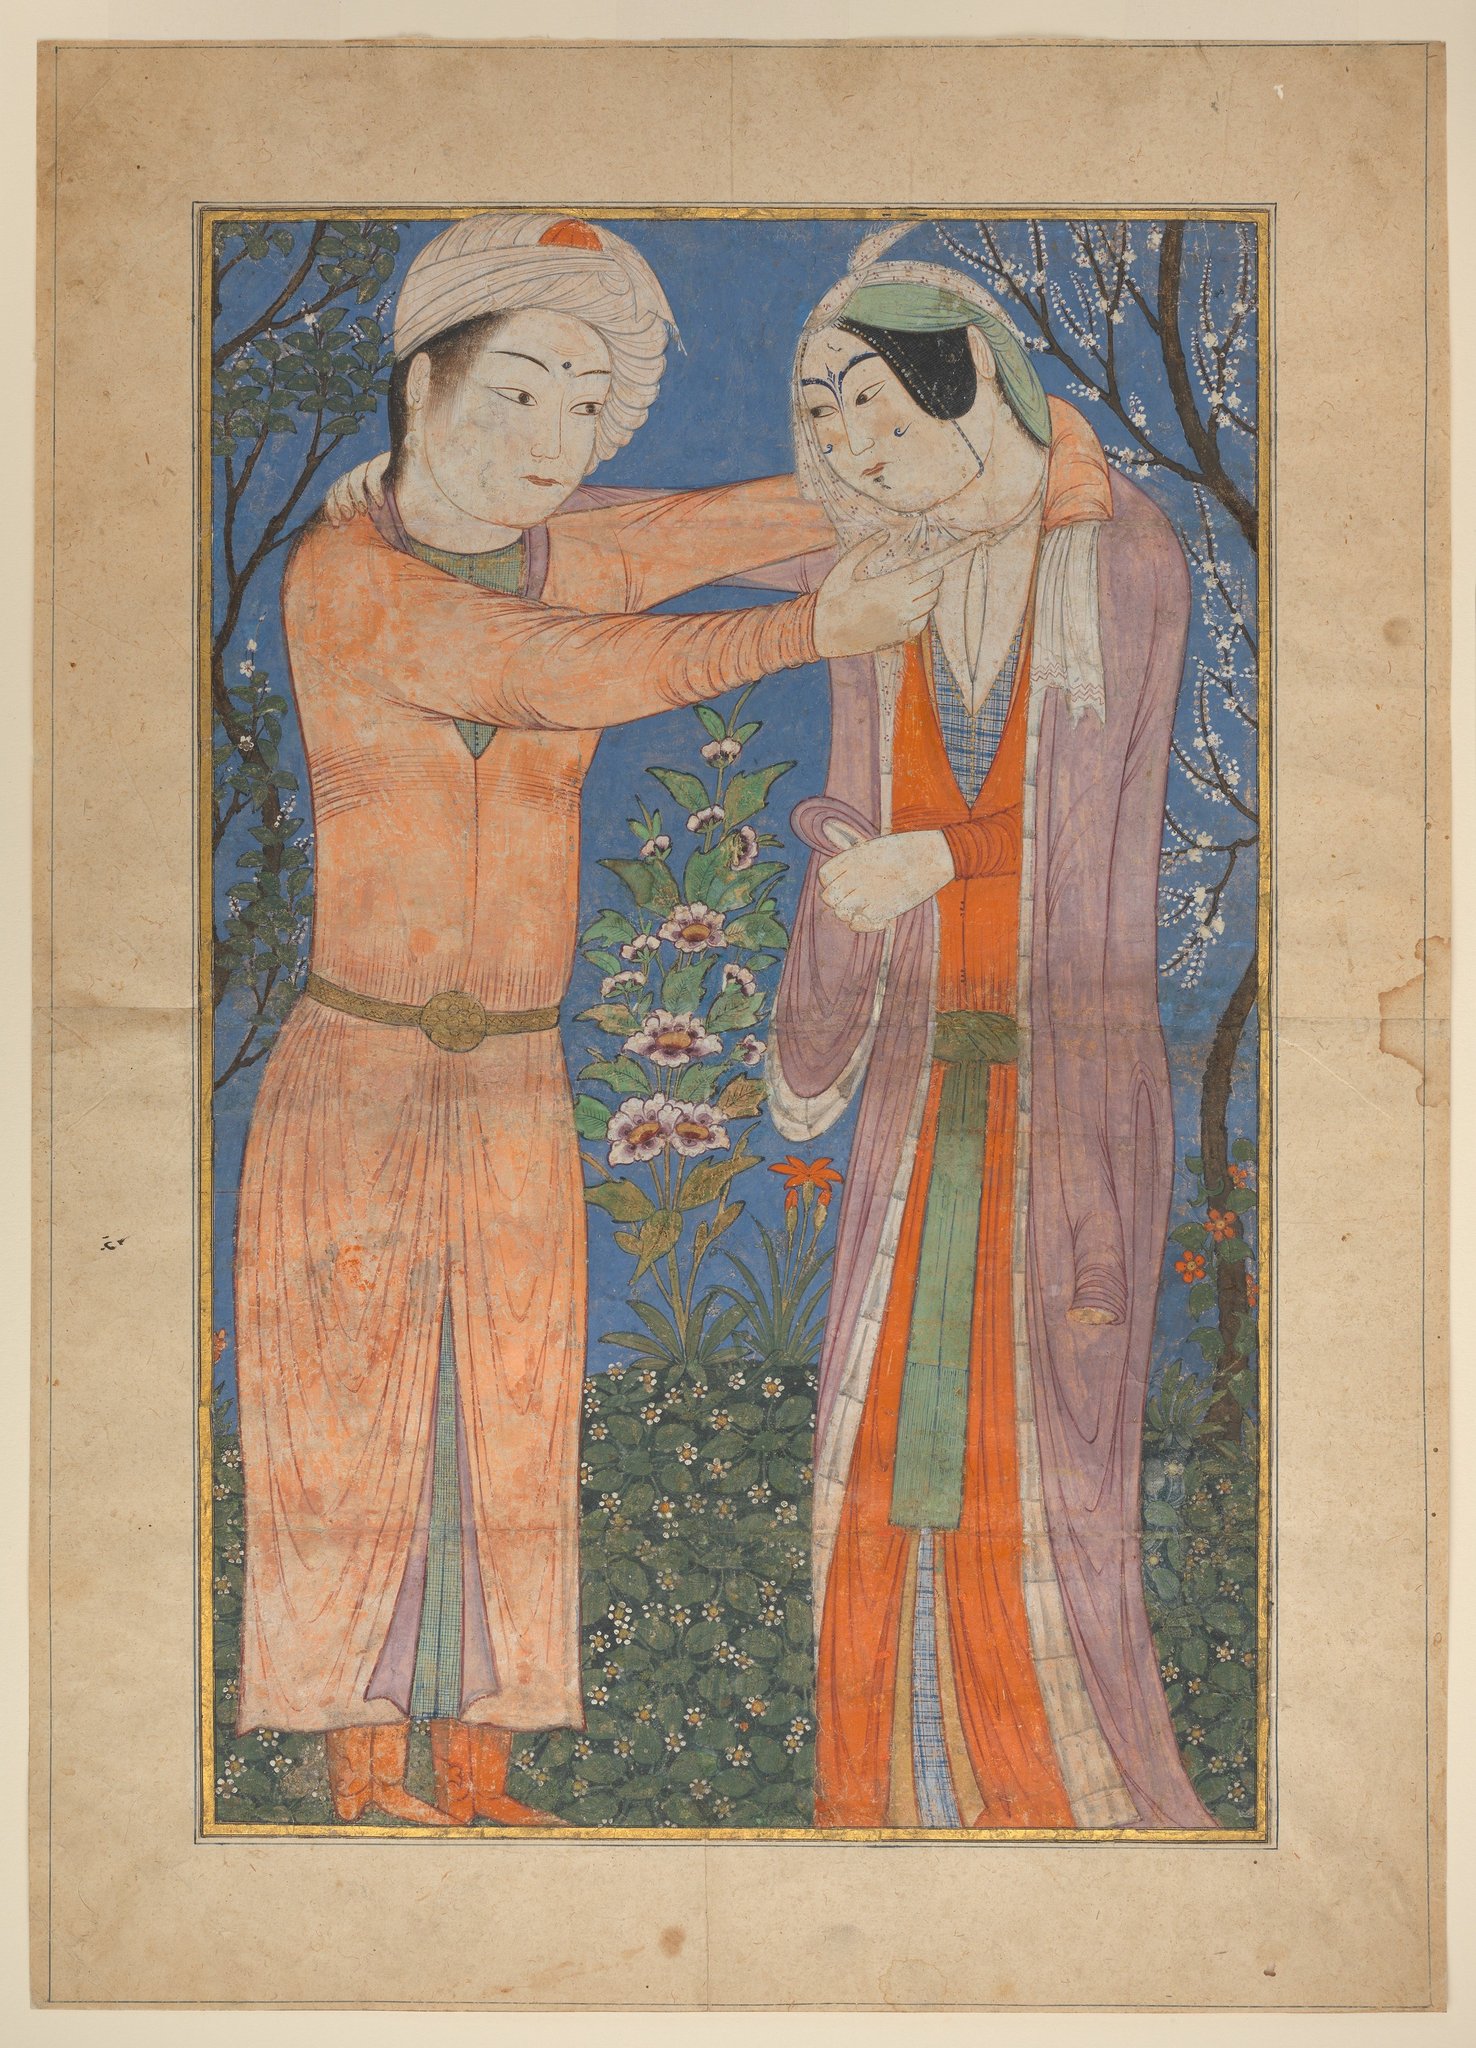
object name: illustrated single work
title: Princely Couple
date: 1400-1405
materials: gold, paper, watercolor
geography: iran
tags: couples,men,lovers,women